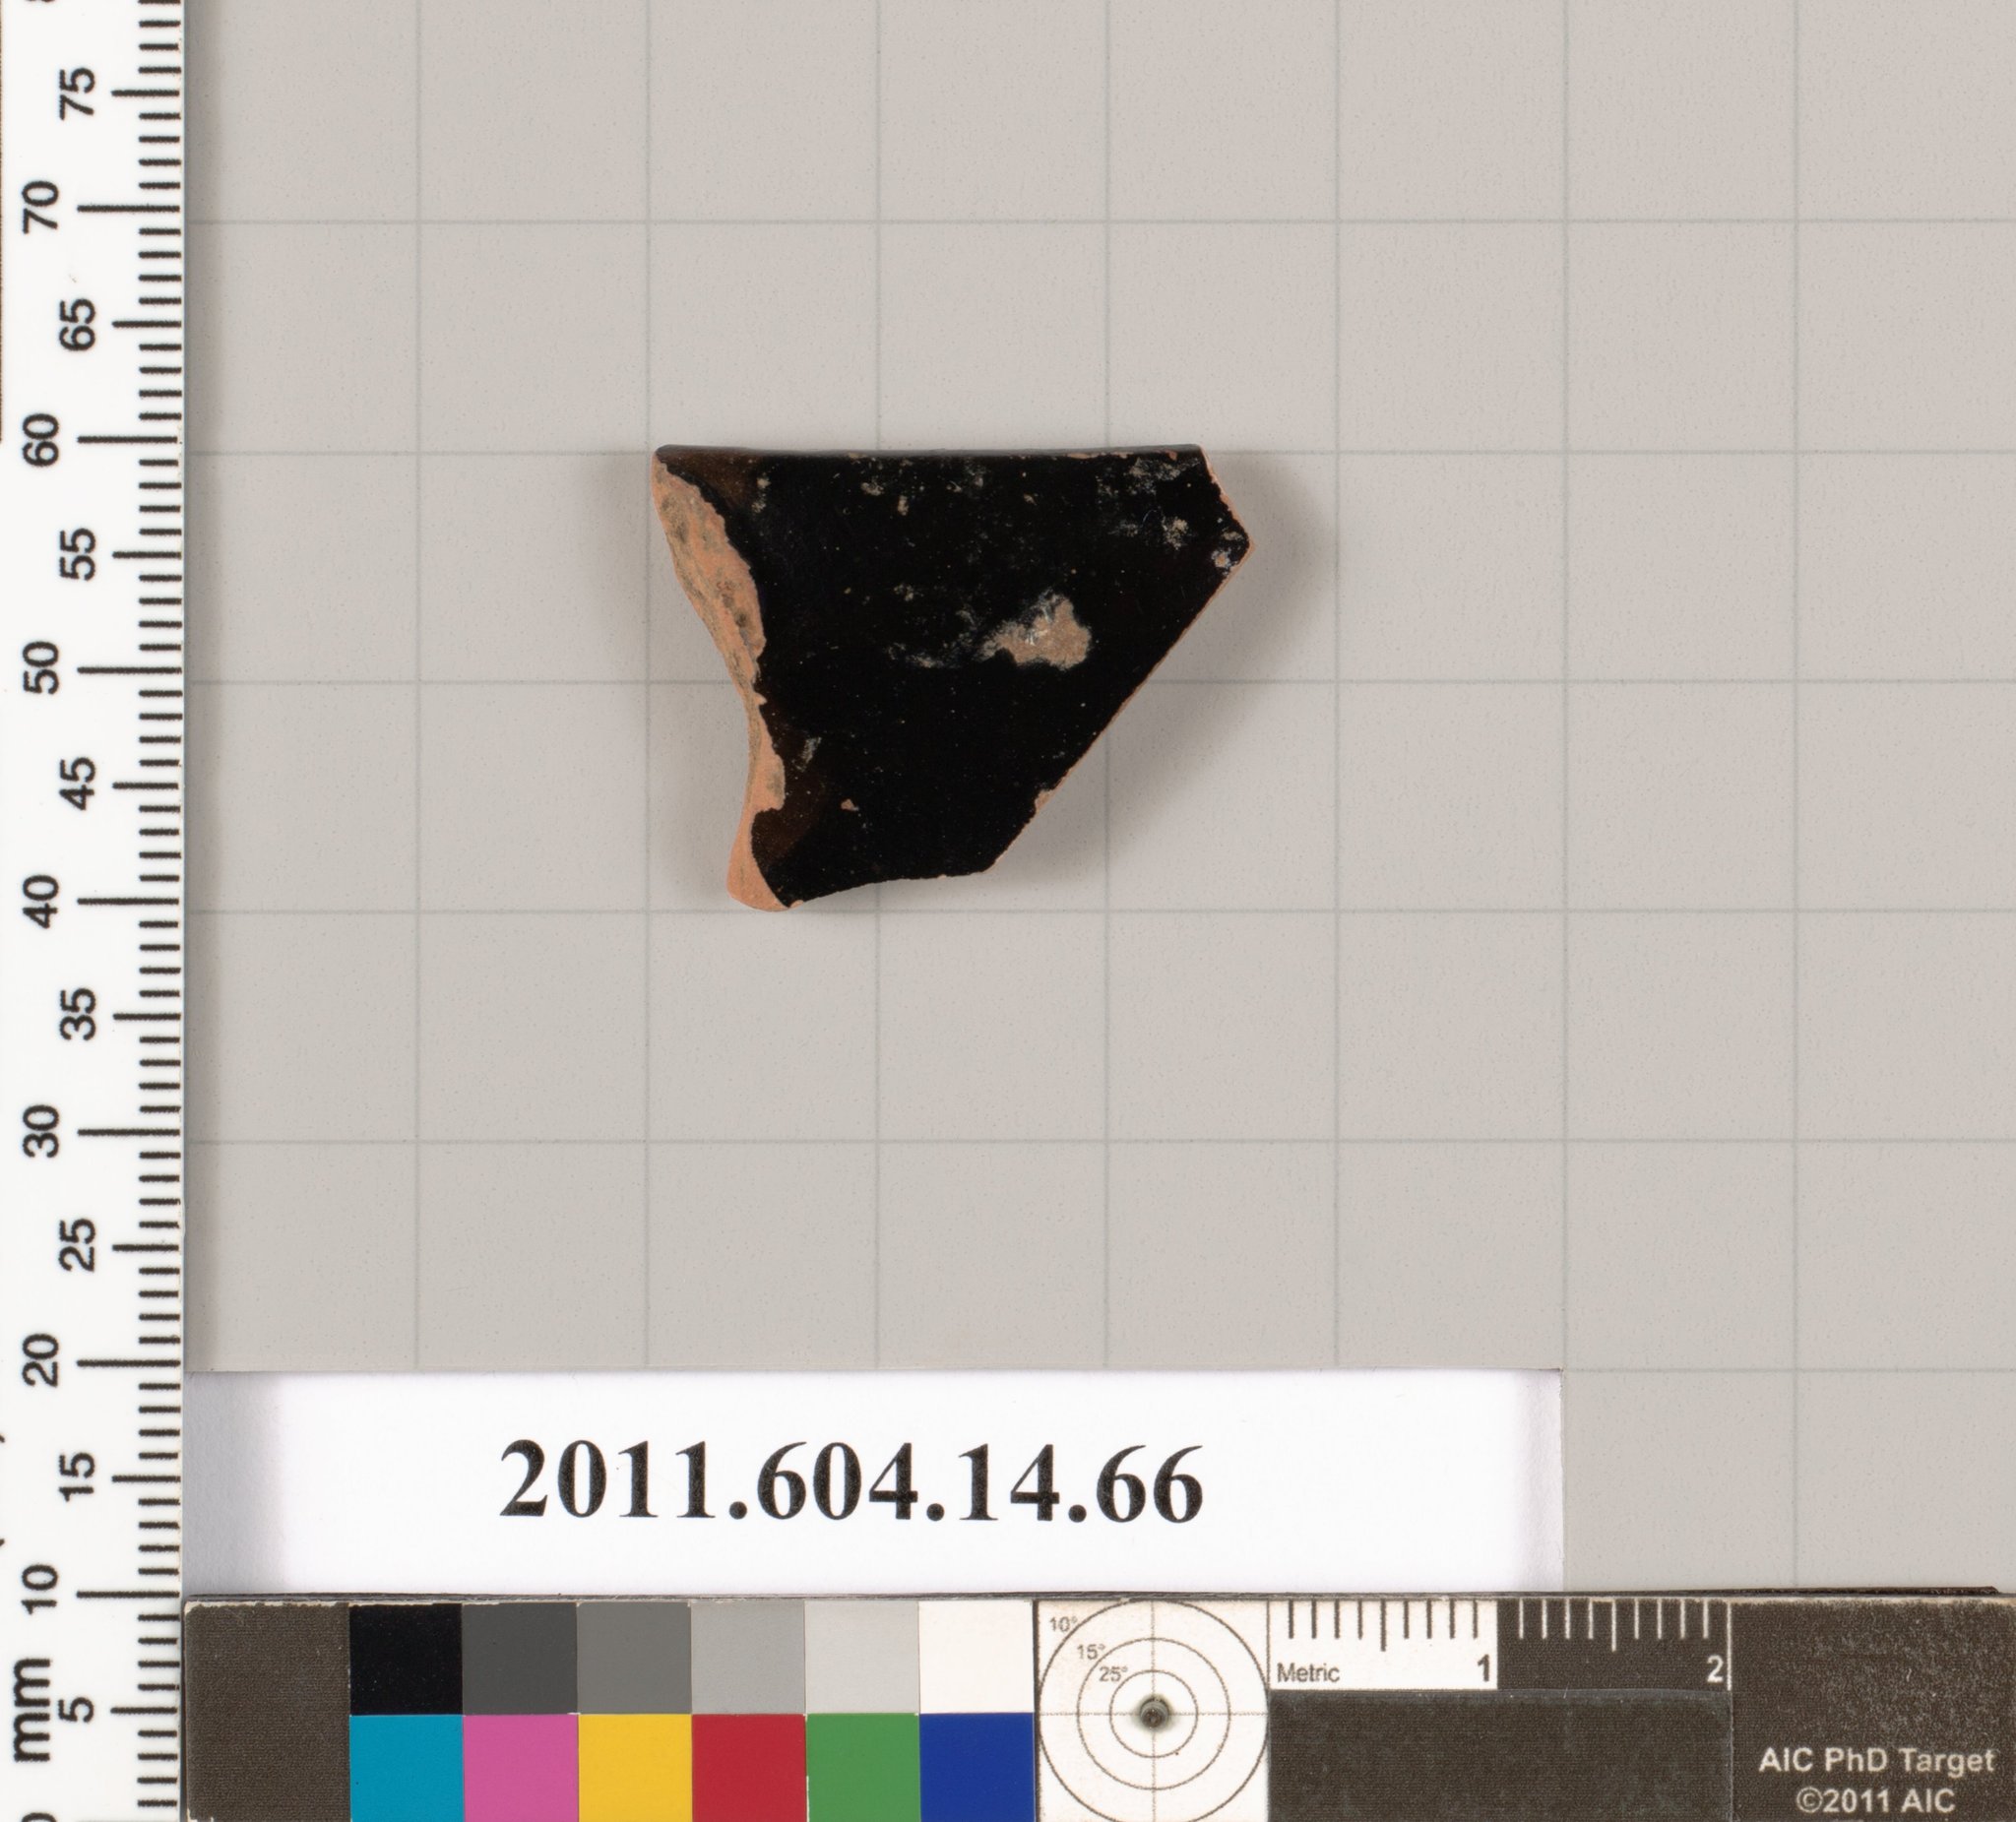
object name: kylix fragment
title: Terracotta rim fragment of a kylix (drinking cup)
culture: unknown fabric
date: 600-401 BCE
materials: terracotta